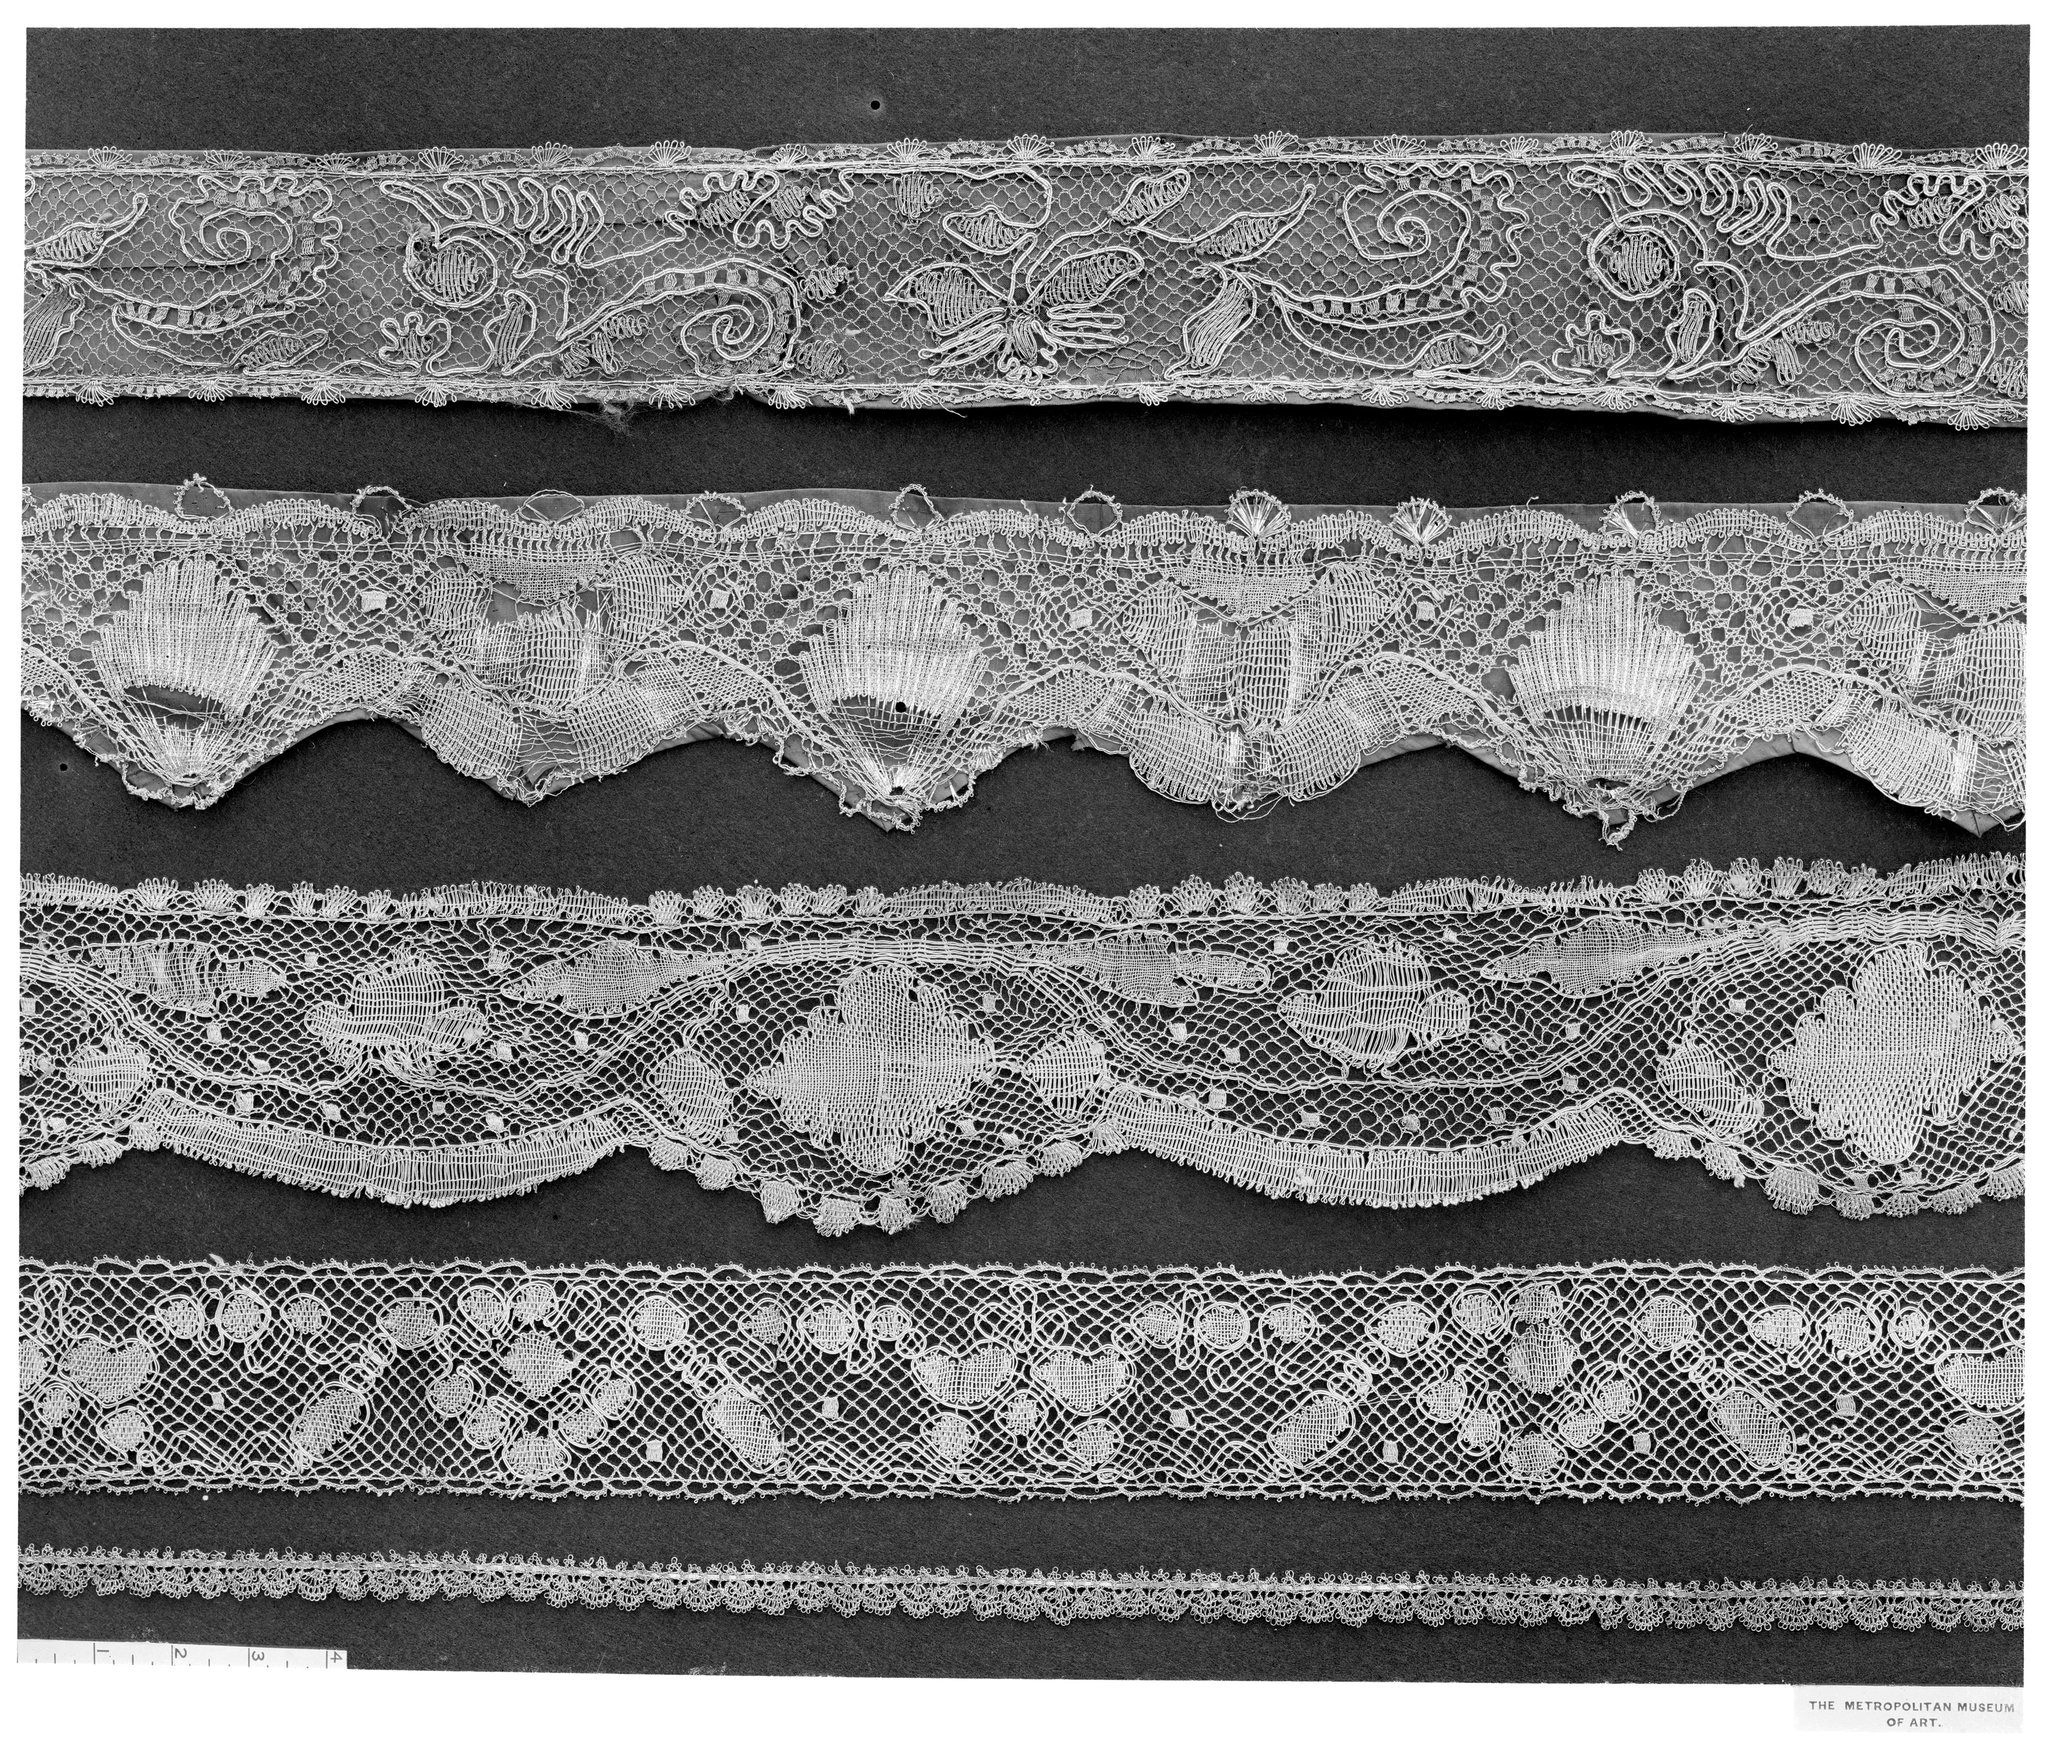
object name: fragment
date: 1767-1800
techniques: lace